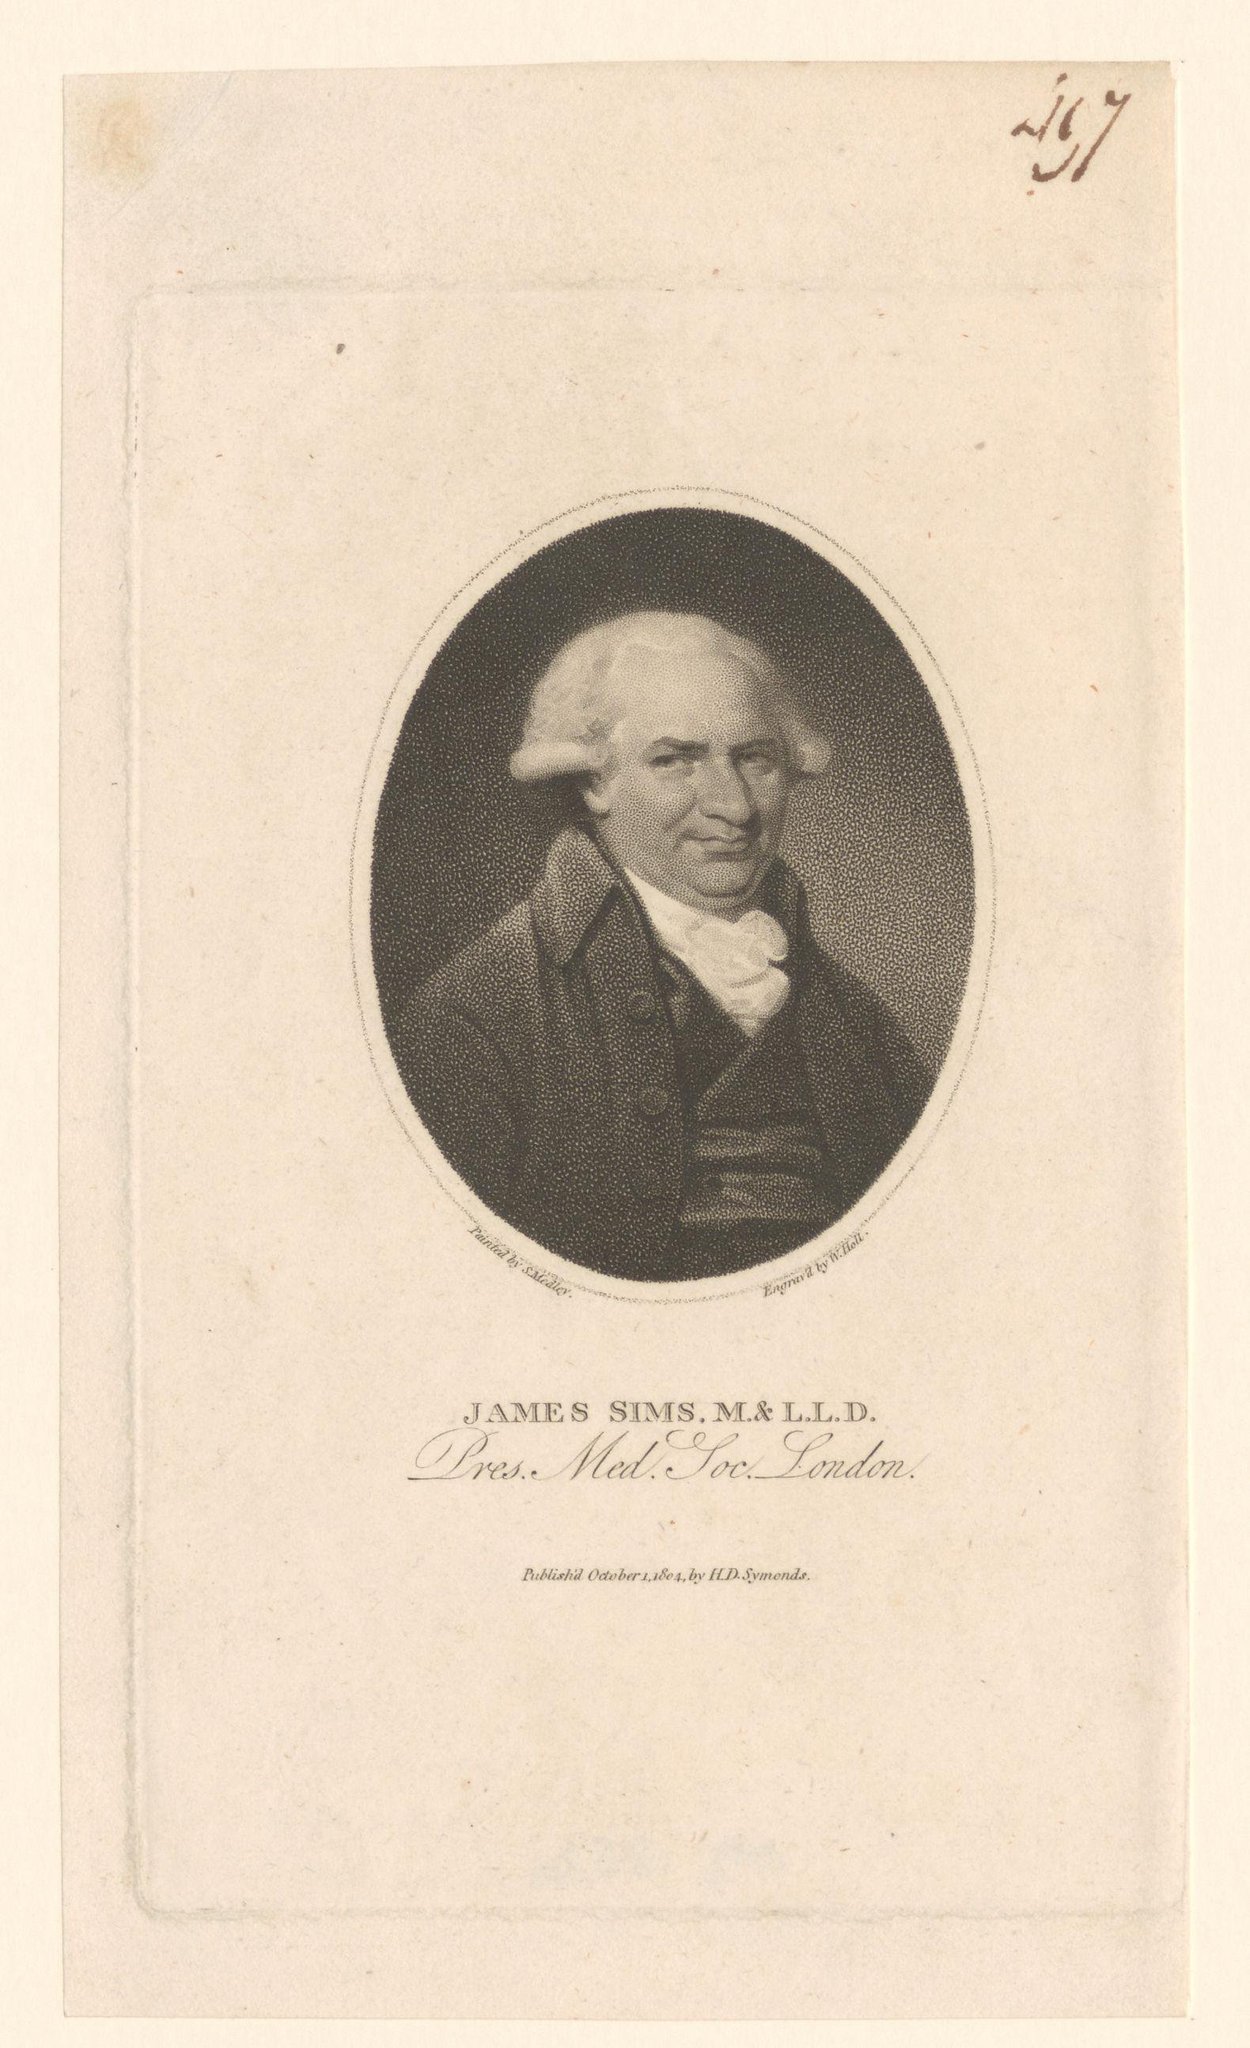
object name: print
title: James Sims M. & L.L.D.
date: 1804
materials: paper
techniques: stippling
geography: london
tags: historical persons, physician, doctor (+ portrait of scholar, scientist)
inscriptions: collector's mark: Lugt 2228